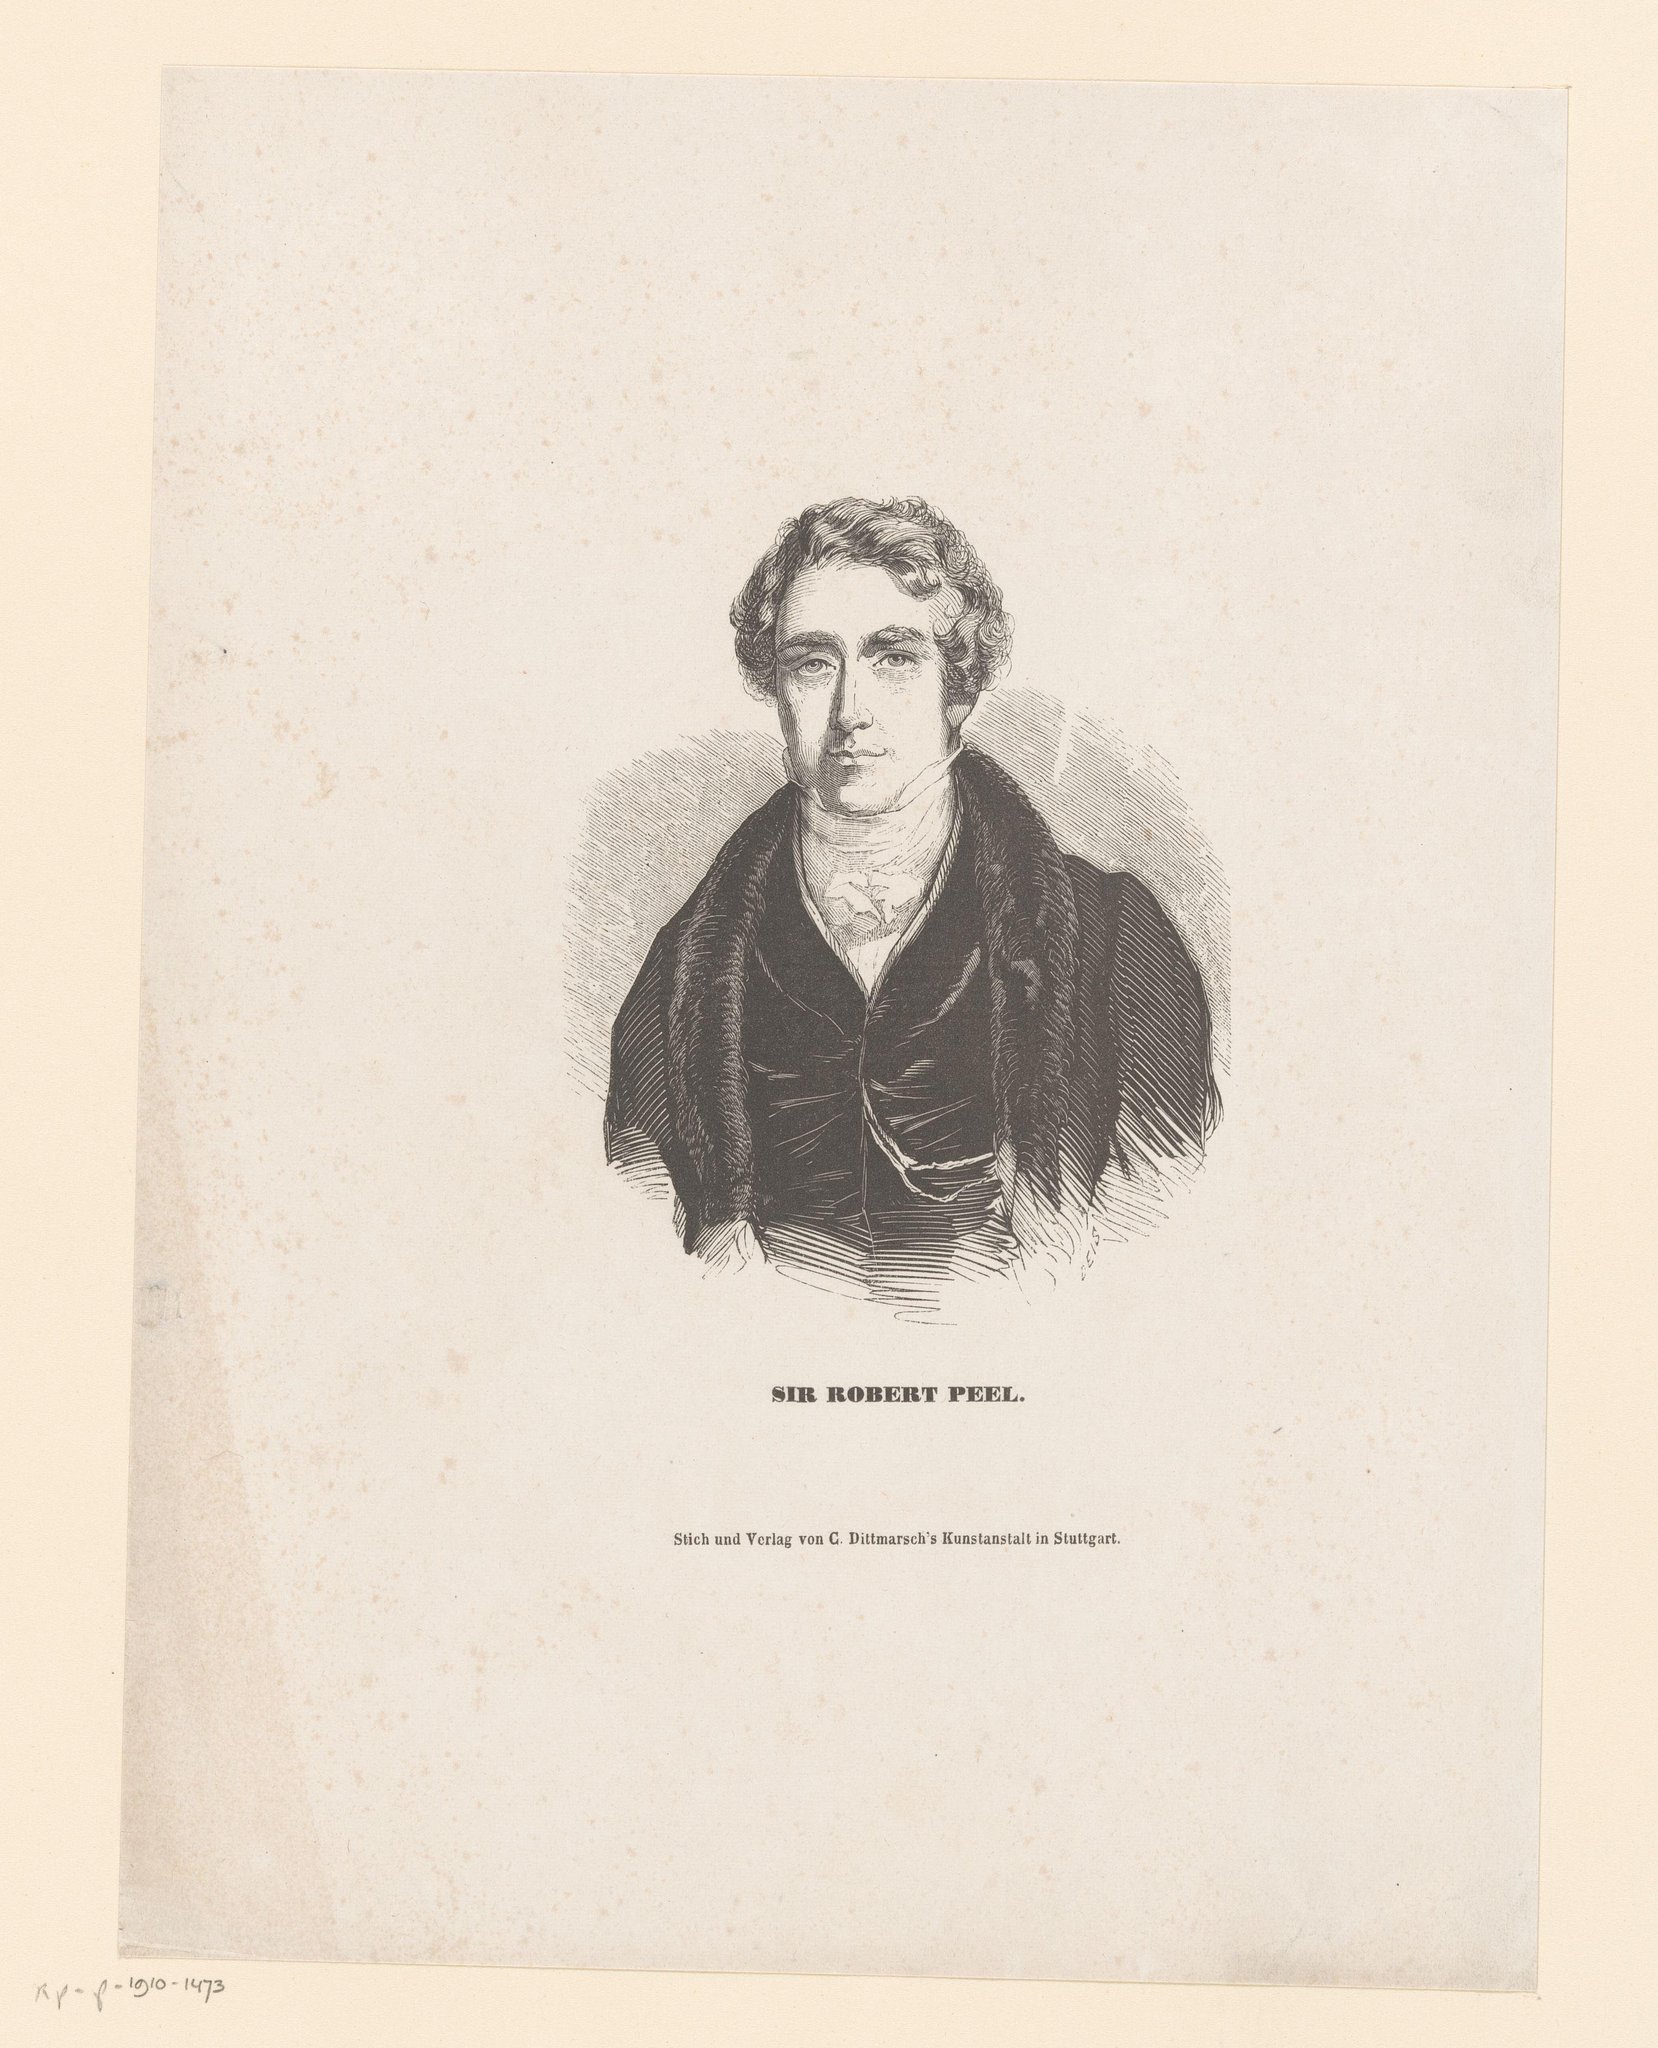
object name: print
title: Portret van Robert Peel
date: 1824-1899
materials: paper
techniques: engraving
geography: stuttgart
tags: london, historical persons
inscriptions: collector's mark: Lugt 2228